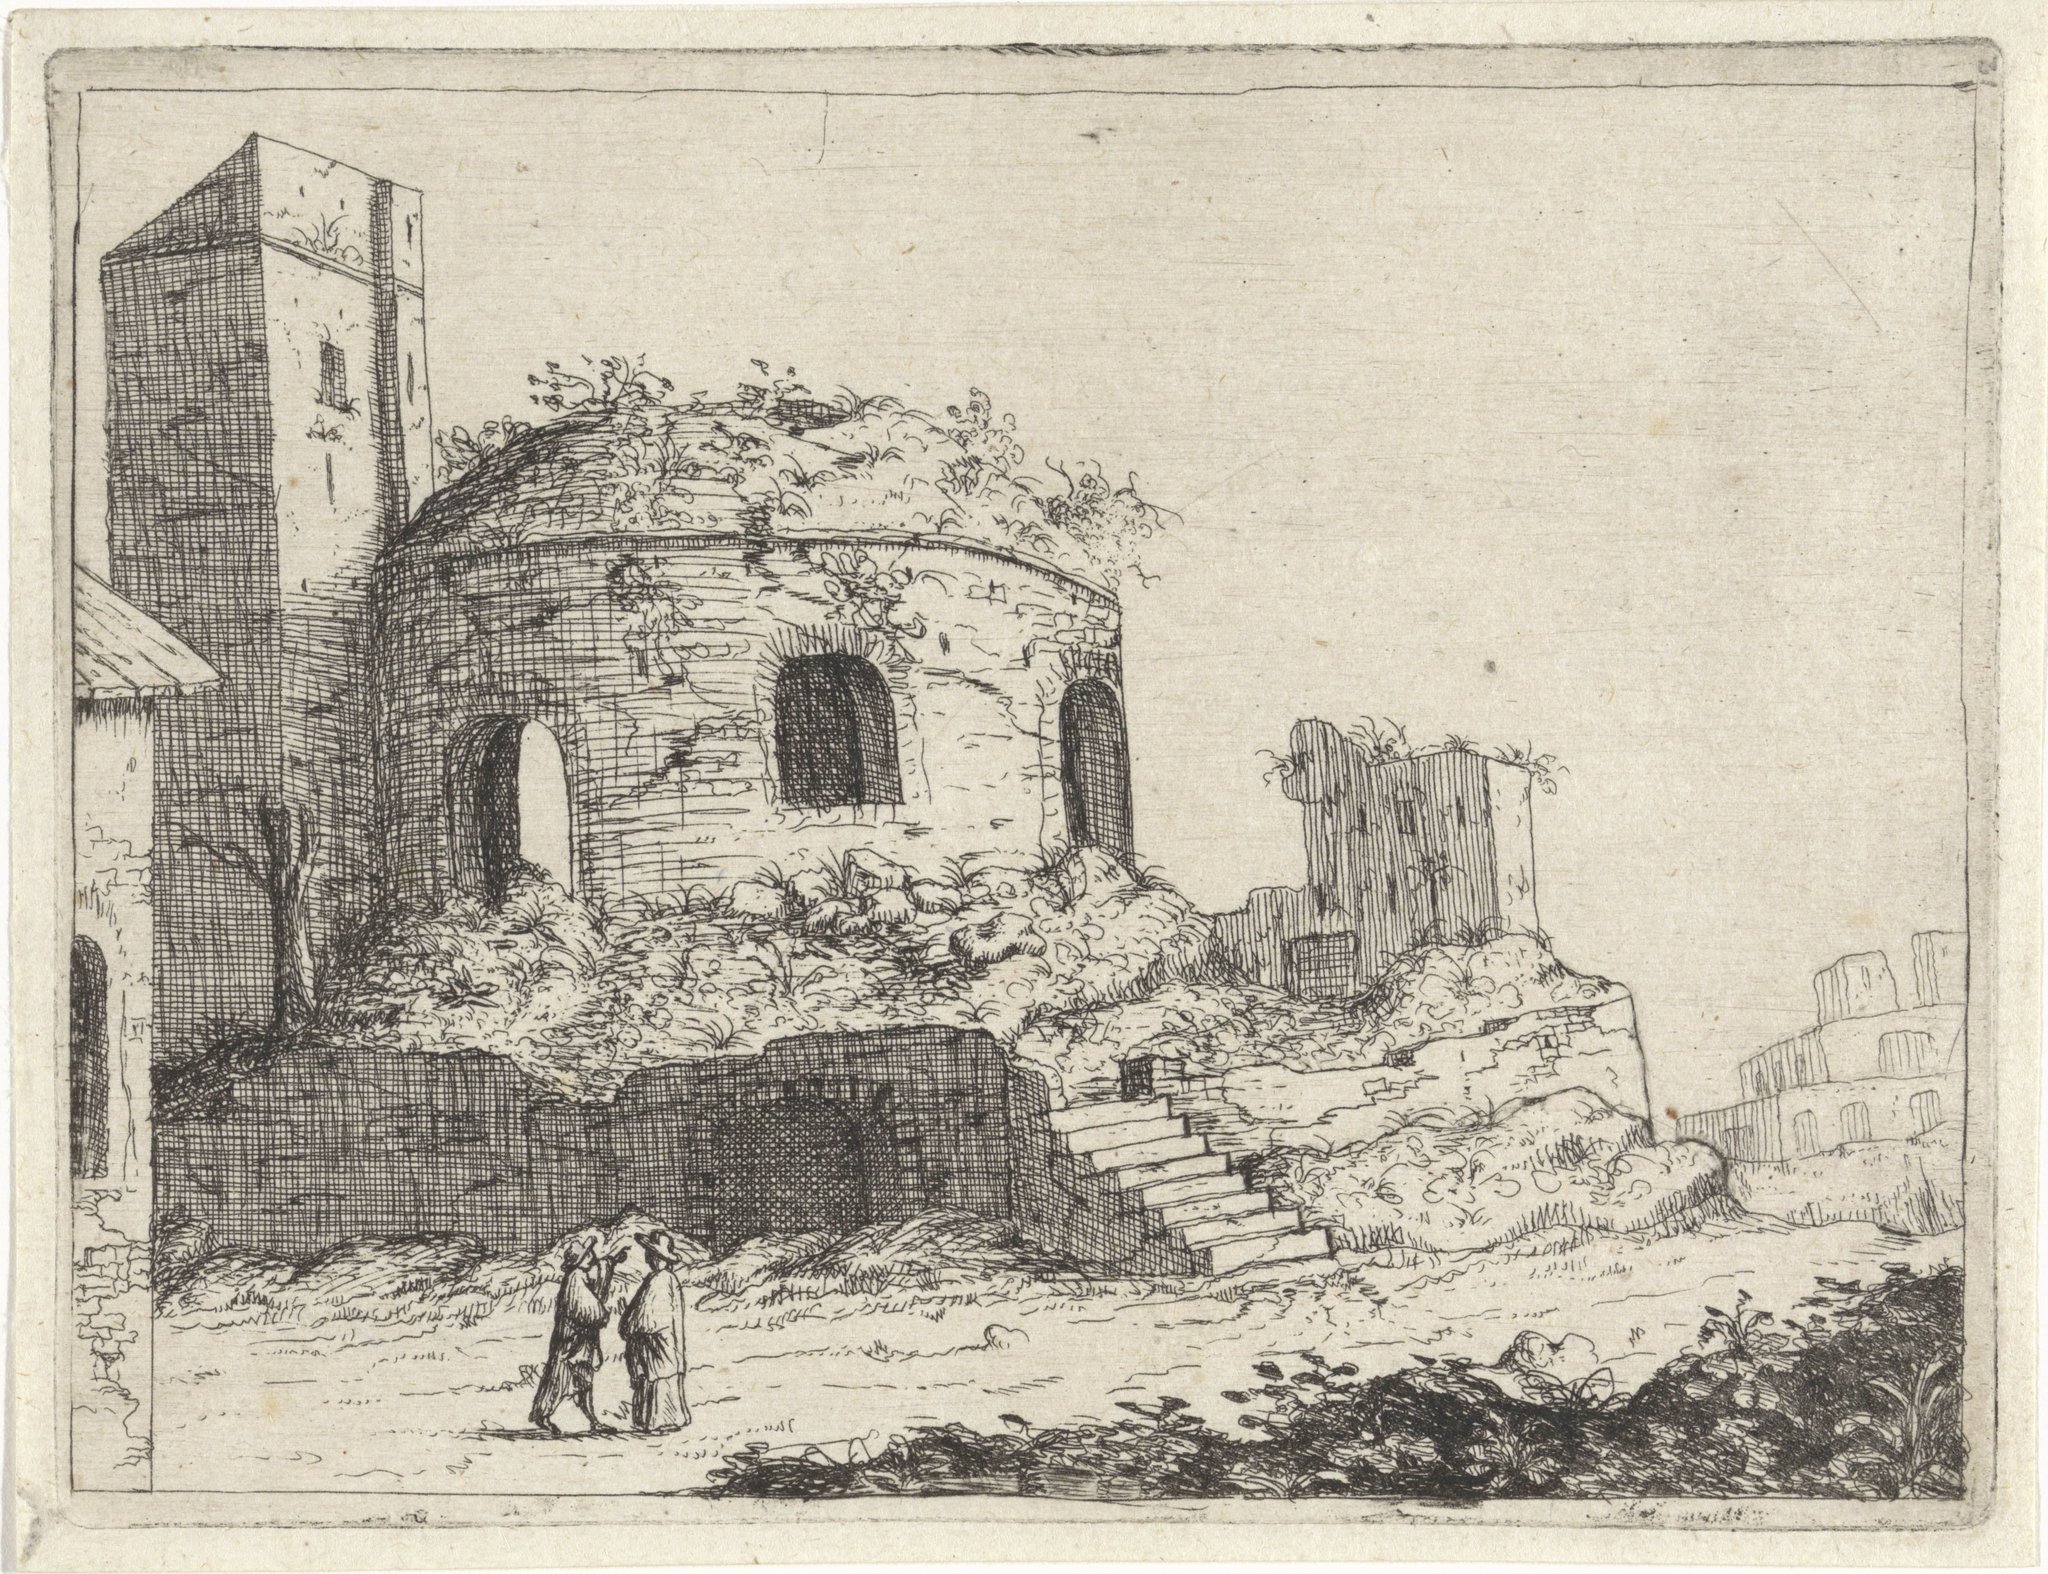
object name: print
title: Romeinse tempel met een toren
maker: m. schaep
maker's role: print maker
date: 1648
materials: paper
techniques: etching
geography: amsterdam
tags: ruin of a building ~ architecture, landscape with ruins, temple, shrine ~ roman religion, tower (of house or building)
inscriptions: collector's mark: Lugt 240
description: Op een verhoging met een trap ligt een ronde, Romeinse tempel met een koepel en een toren. Vooraan links staan twee figuren.